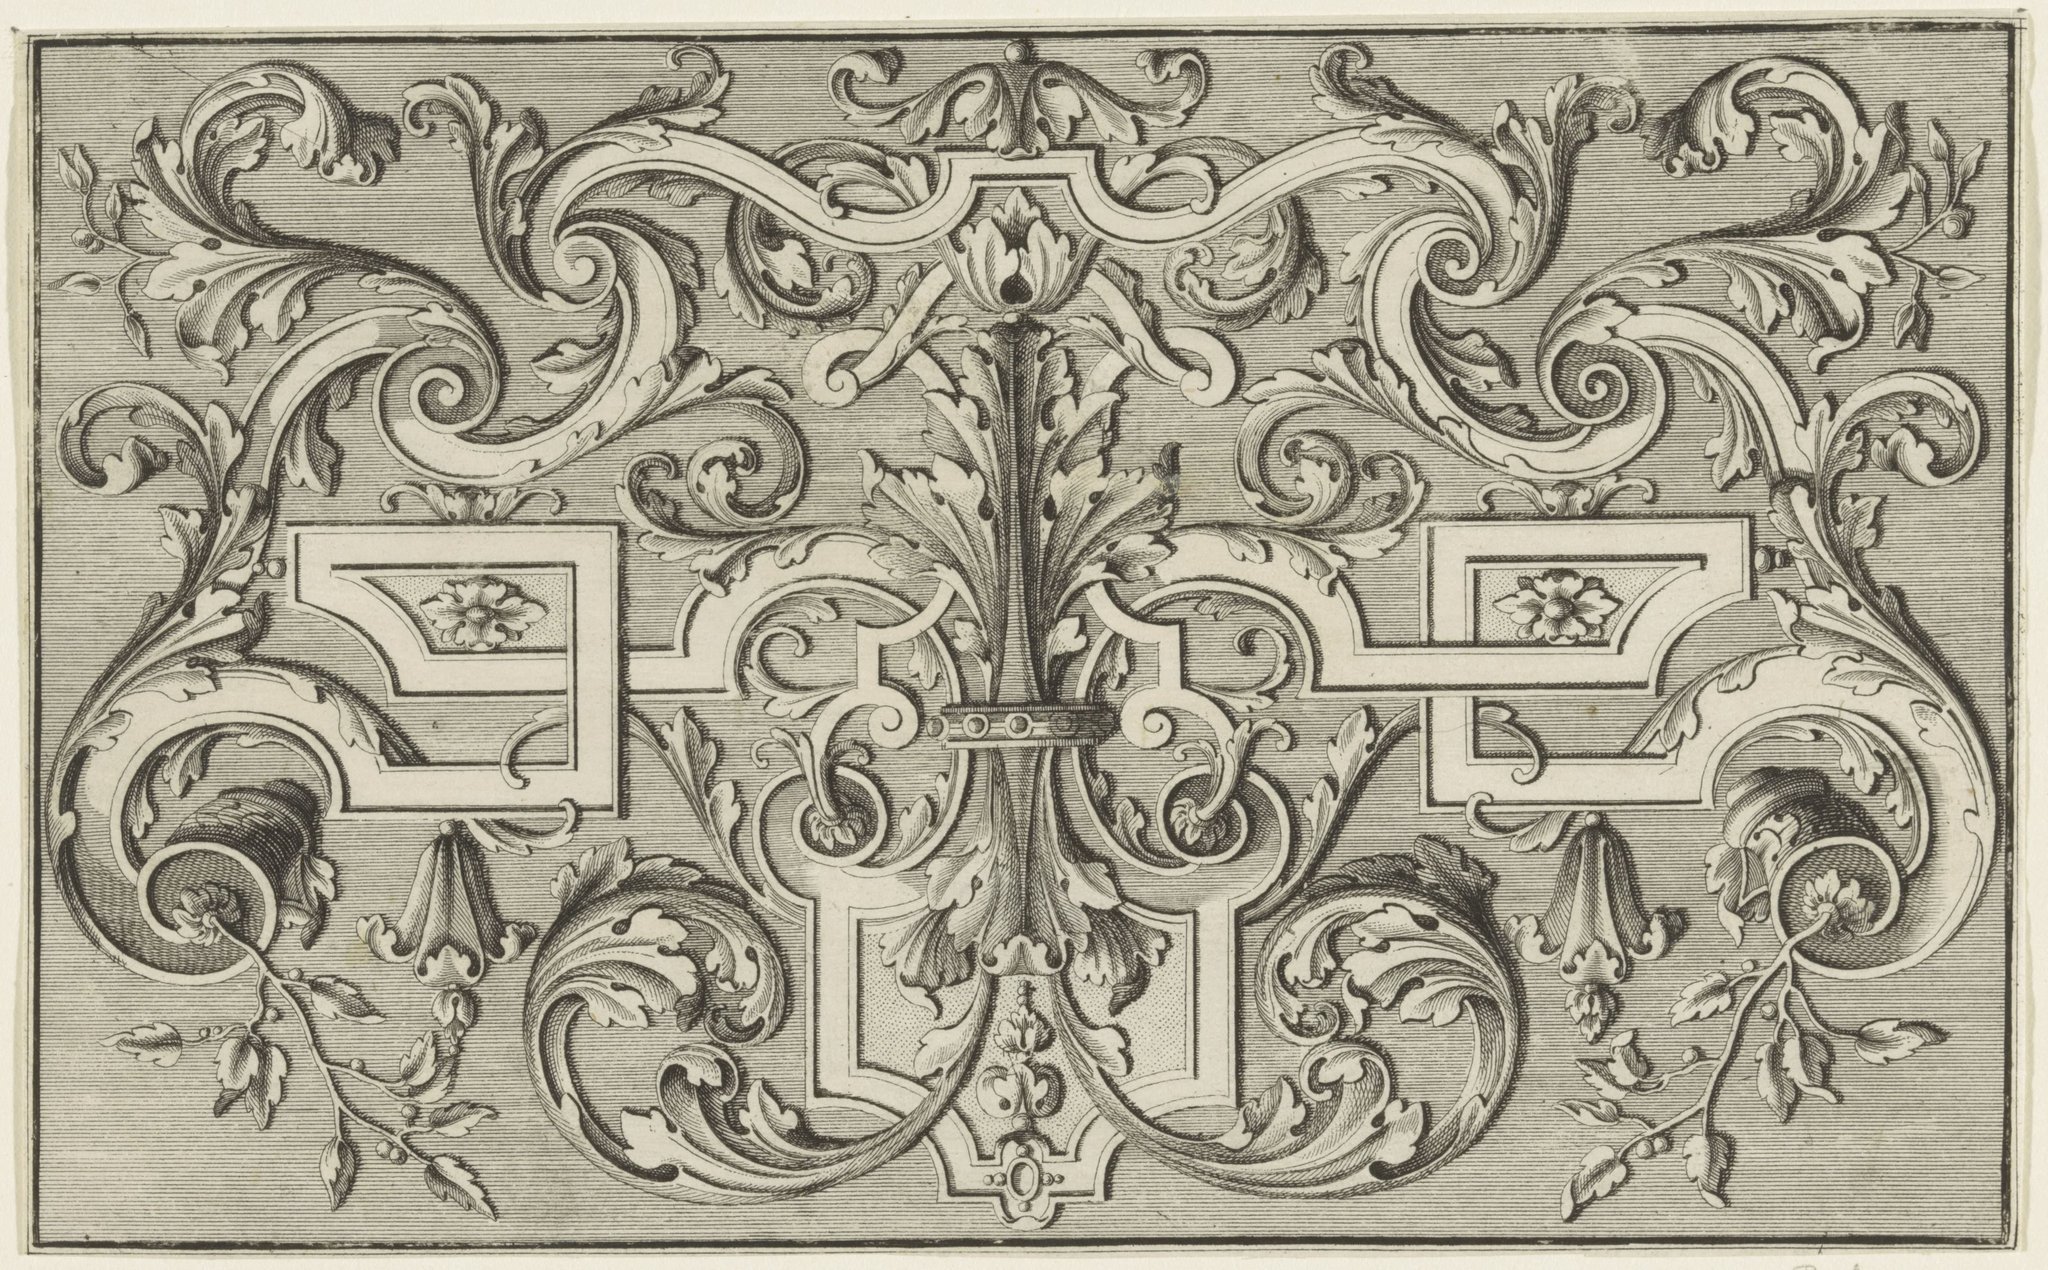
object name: ornament print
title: Arabesken met vlechtwerk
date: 1726-1734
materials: paper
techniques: etching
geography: nuremberg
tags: ornament ~ arabesque, 'laub- und bandelwerk' ~ ornament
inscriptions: collector's mark: Lugt 2228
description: Arabesken met bladeren, bloemen en vlechtwerk links, onder en rechts van midden.